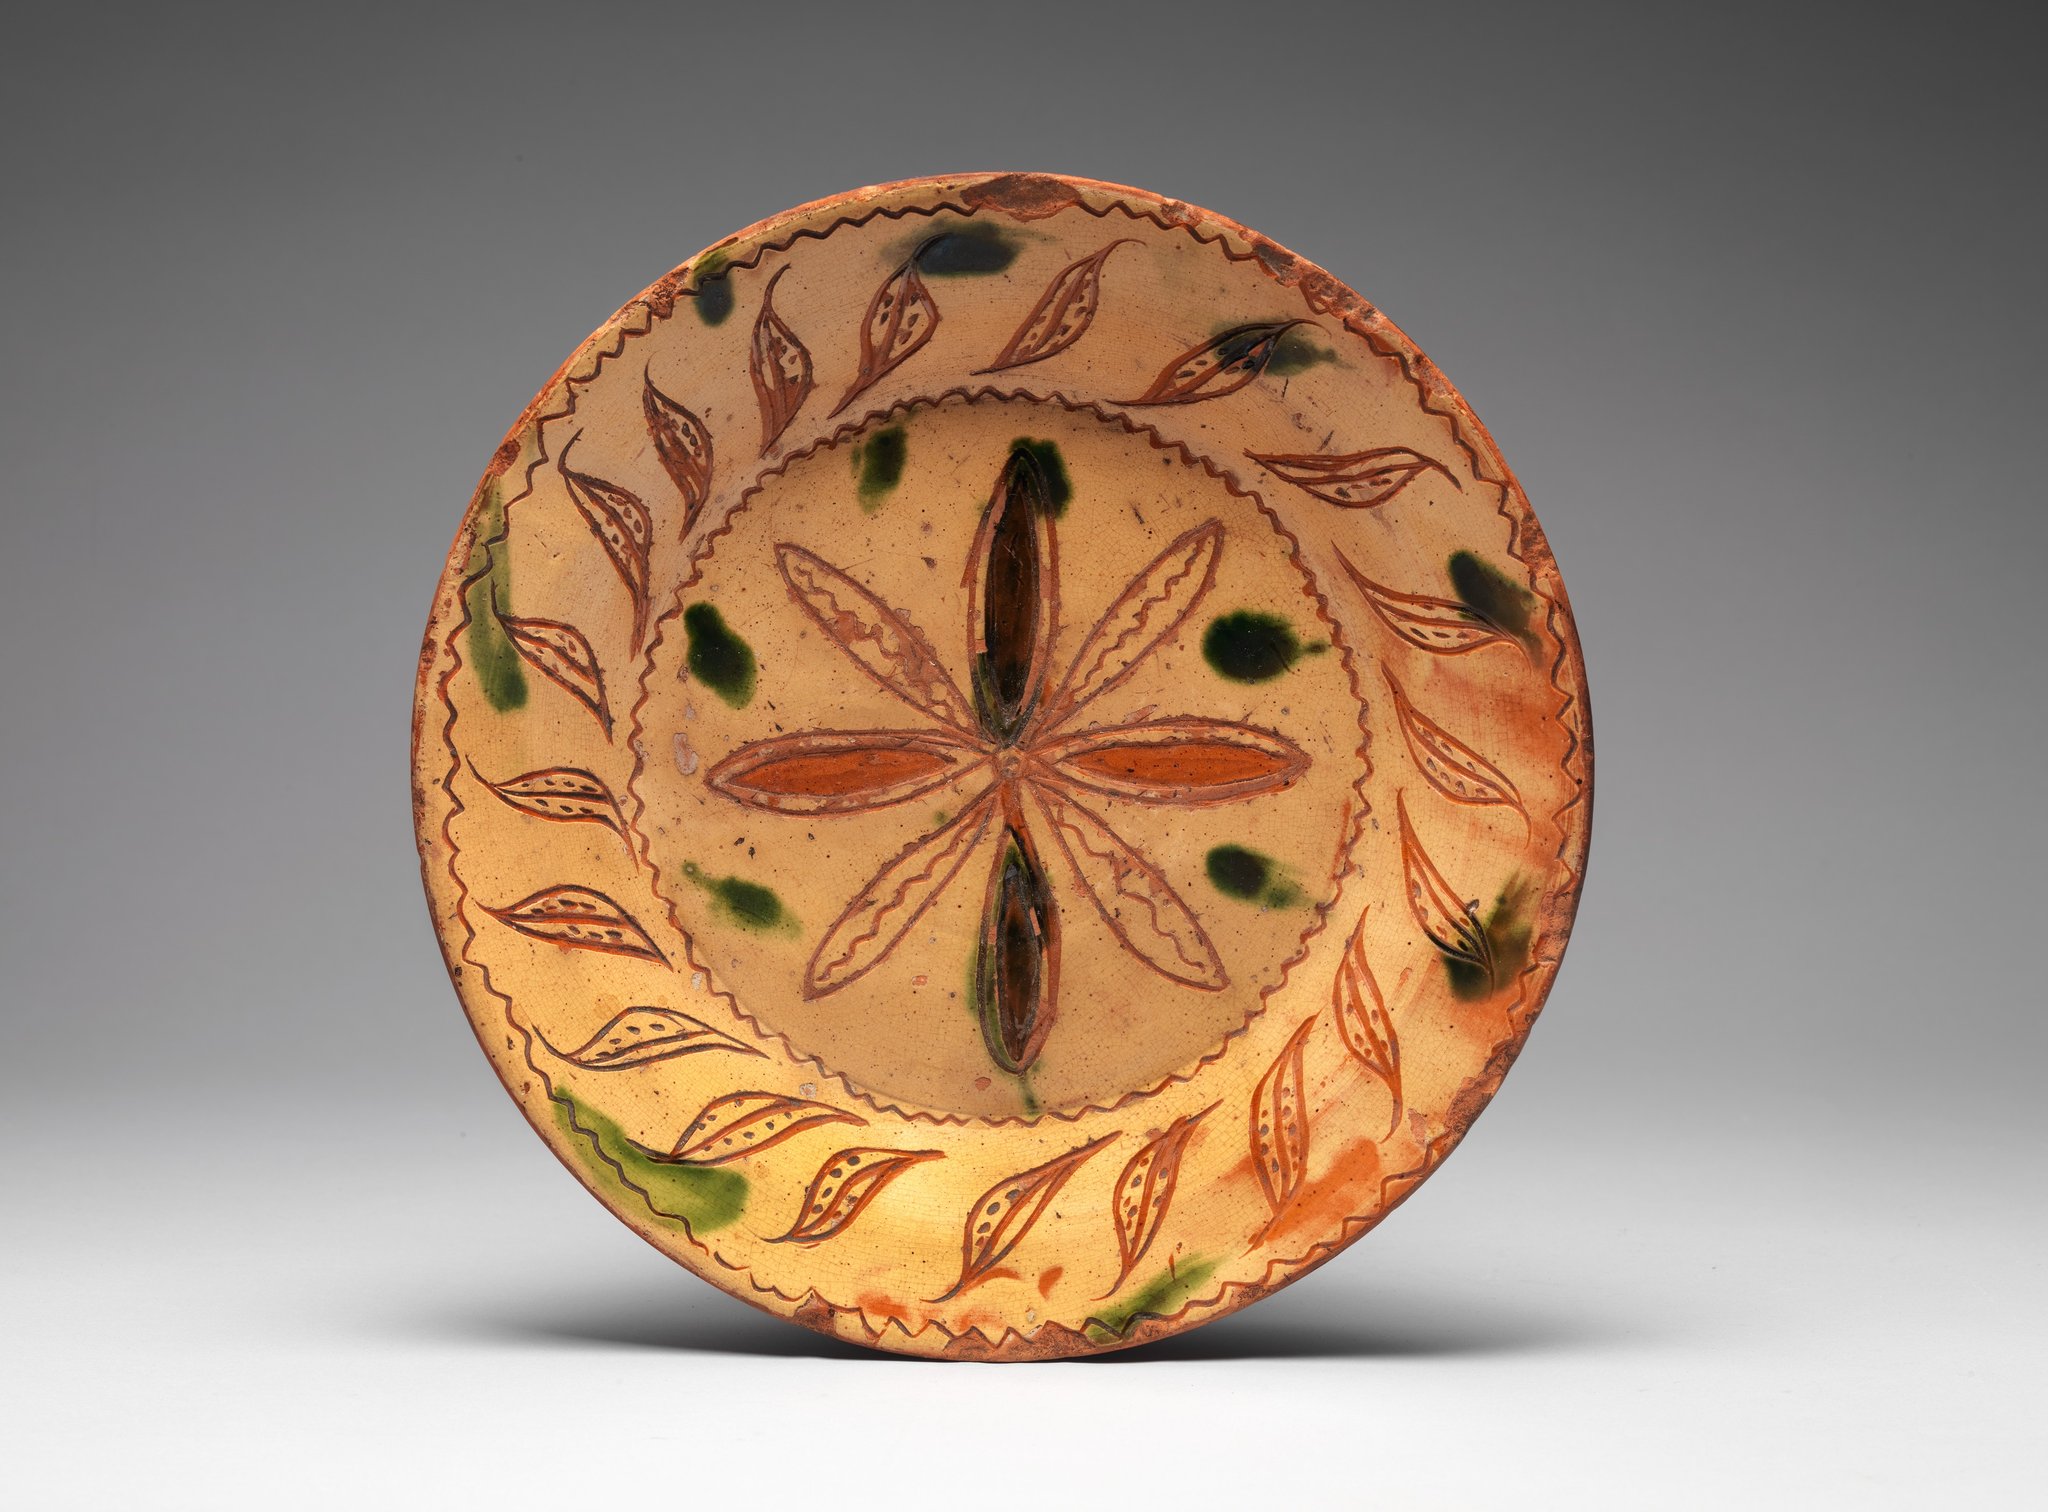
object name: plate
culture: american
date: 1780-1825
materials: earthenware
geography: united states